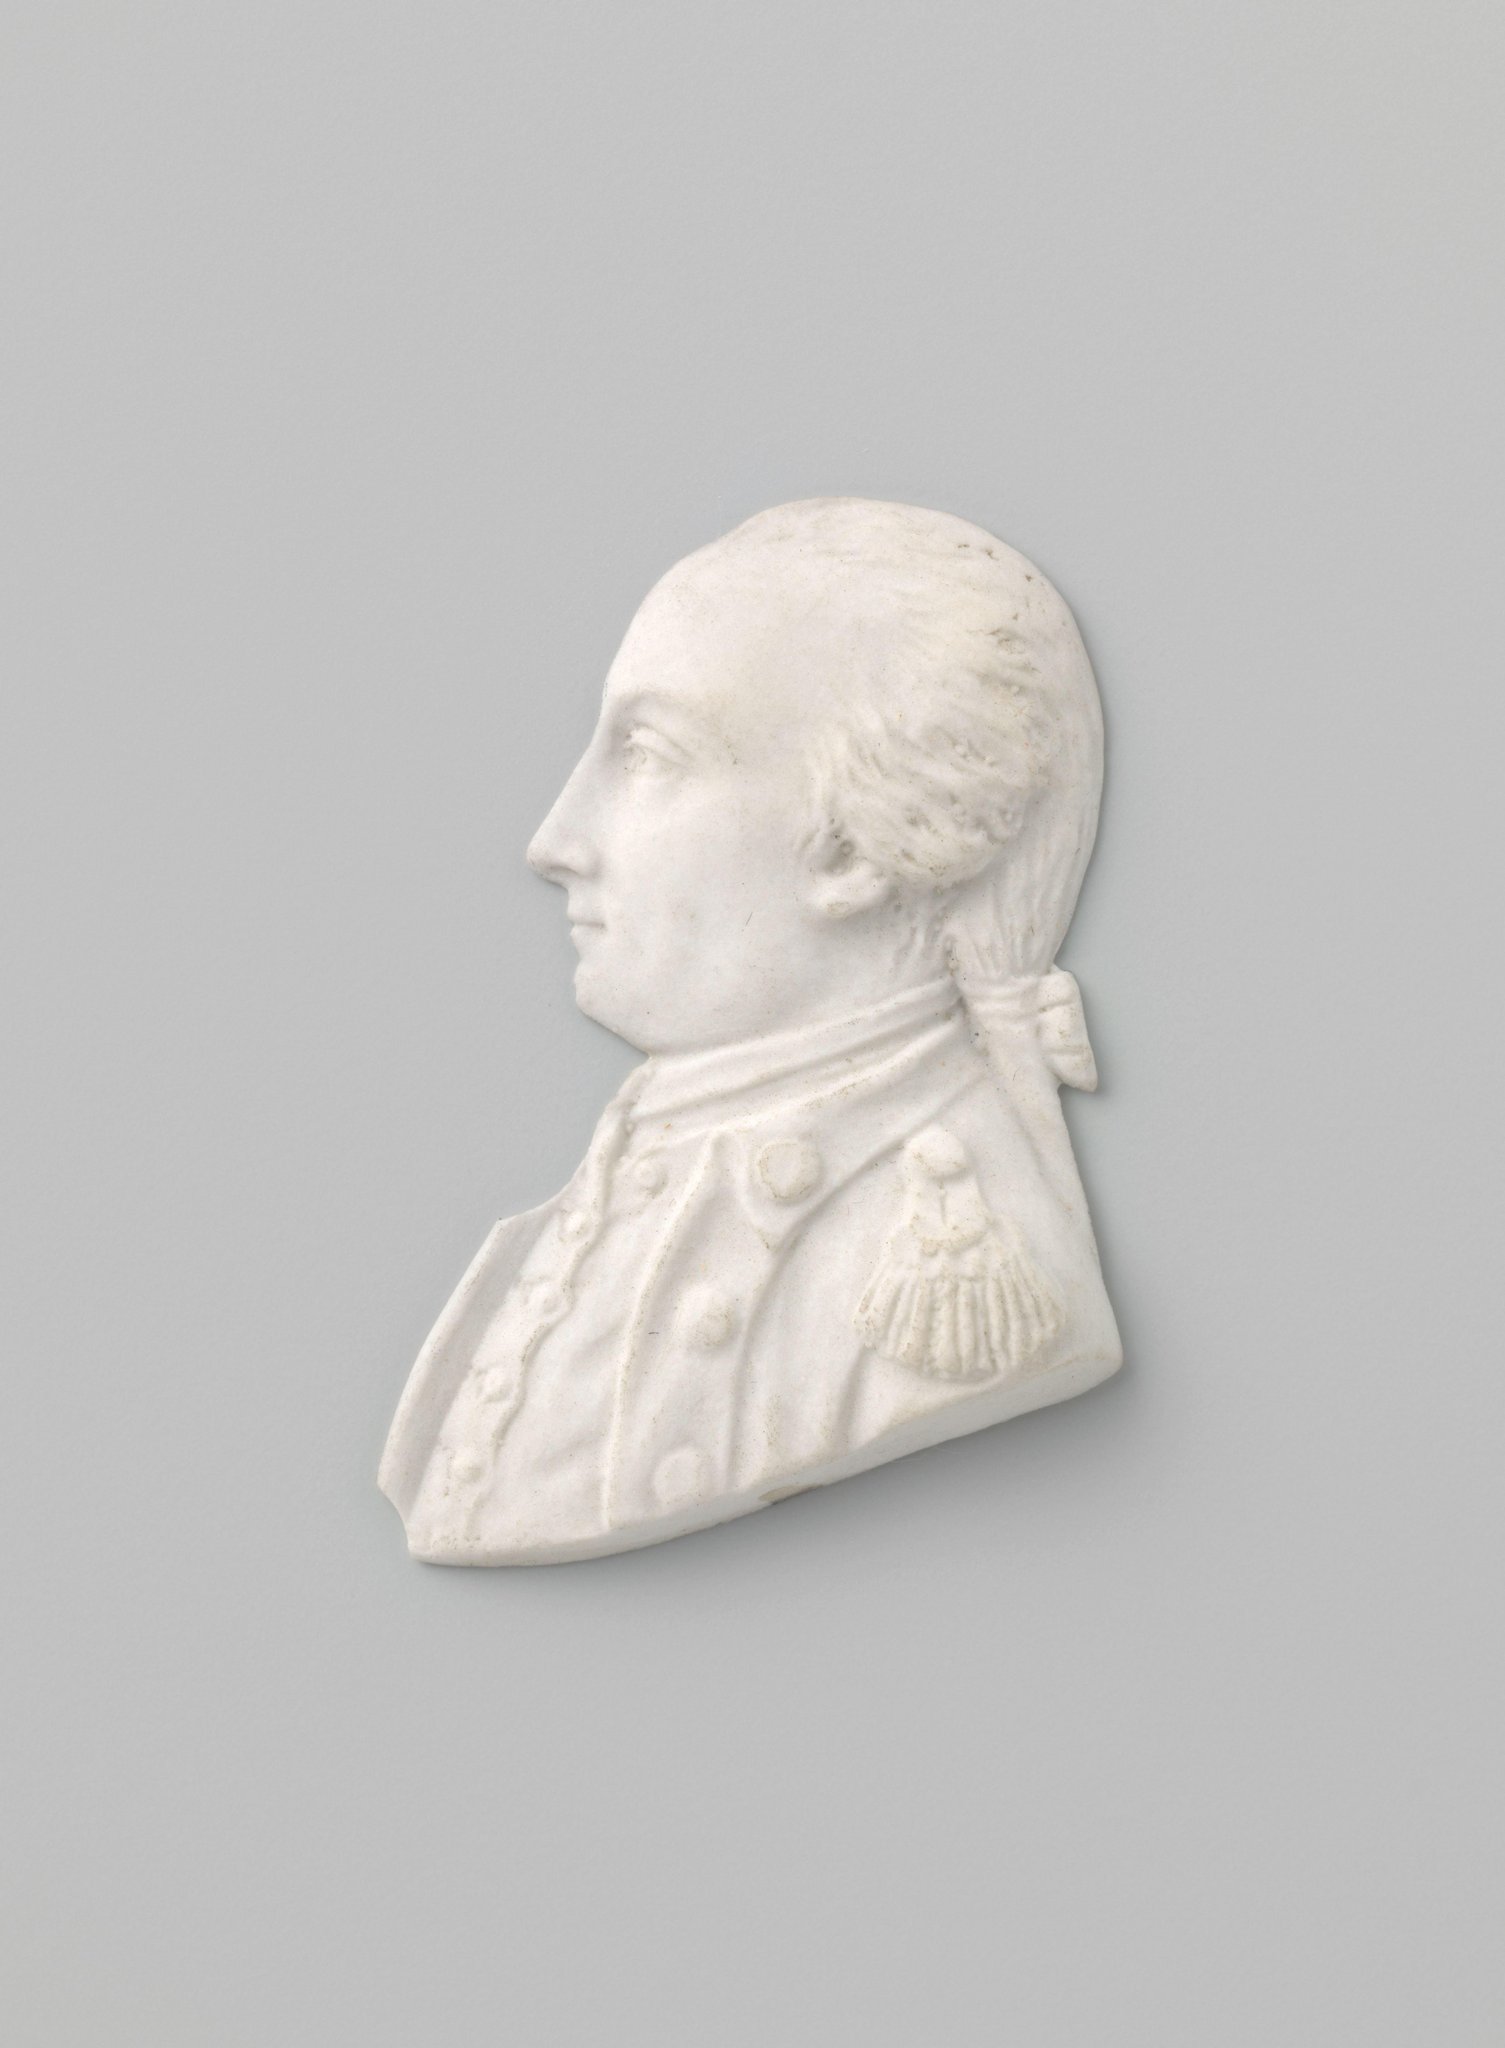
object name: relief sculpture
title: Portrait of Louis Philippe II, Duke of Orléans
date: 1780-1795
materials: porcelain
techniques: forming, relief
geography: sèvres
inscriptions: inscription: ‘EGALITÉ’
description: Portret van porselein in biscuit. Het portret toont Louis Philippe Joseph d'Orléans (1747-1793), ook bekend als Philippe Egalité. Opschrift op de achterzijde met 'EGALITÉ'.